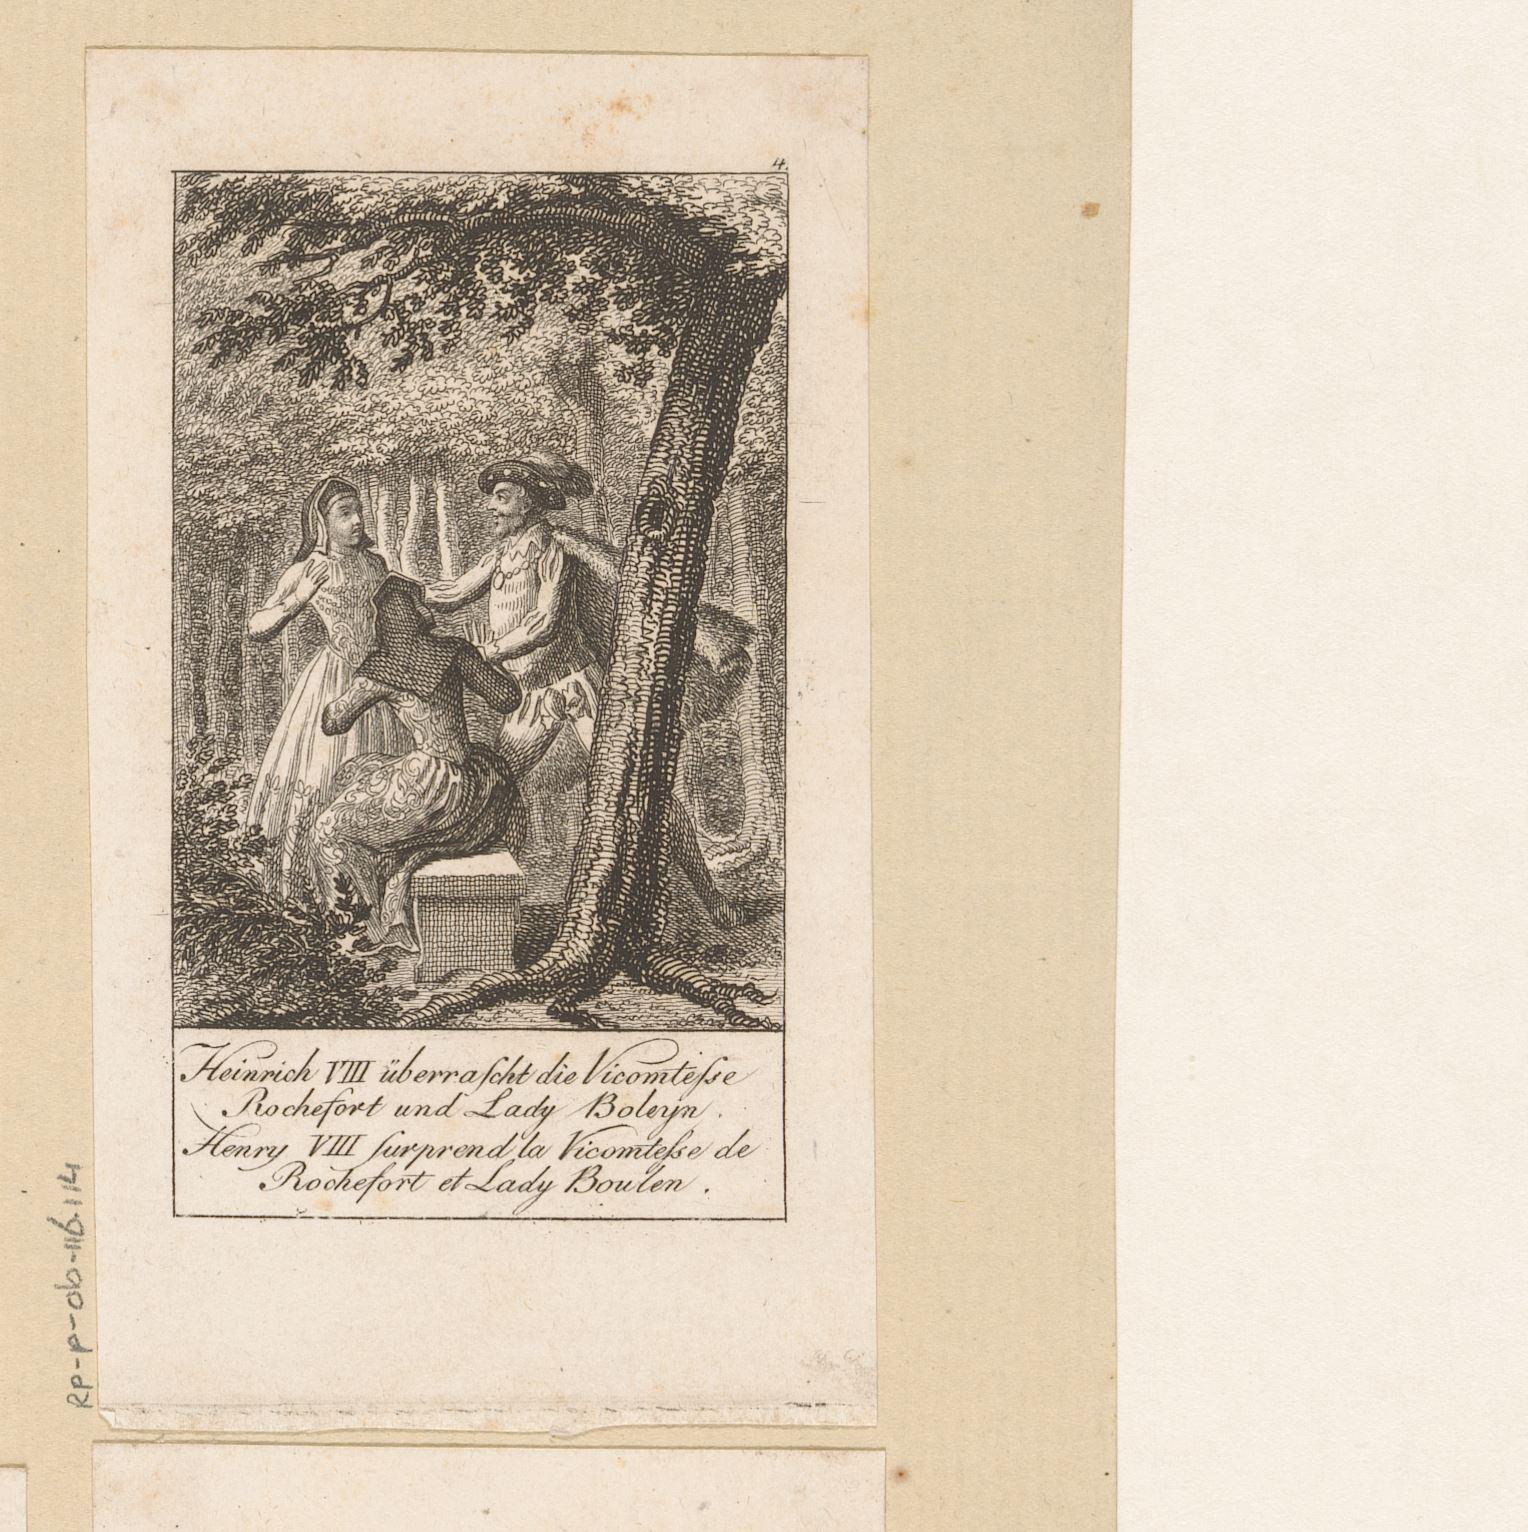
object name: print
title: Voorstelling uit de geschiedenis van Hendrik VIII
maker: christian gottlieb geyser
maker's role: print maker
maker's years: 1742-1803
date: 1796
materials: paper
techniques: etching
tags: london, history, forest, wood, meeting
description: Prent gebruikt voor: Geschichte der Statthalterschaft der Niederlande. Gotha: s.n., 1796.